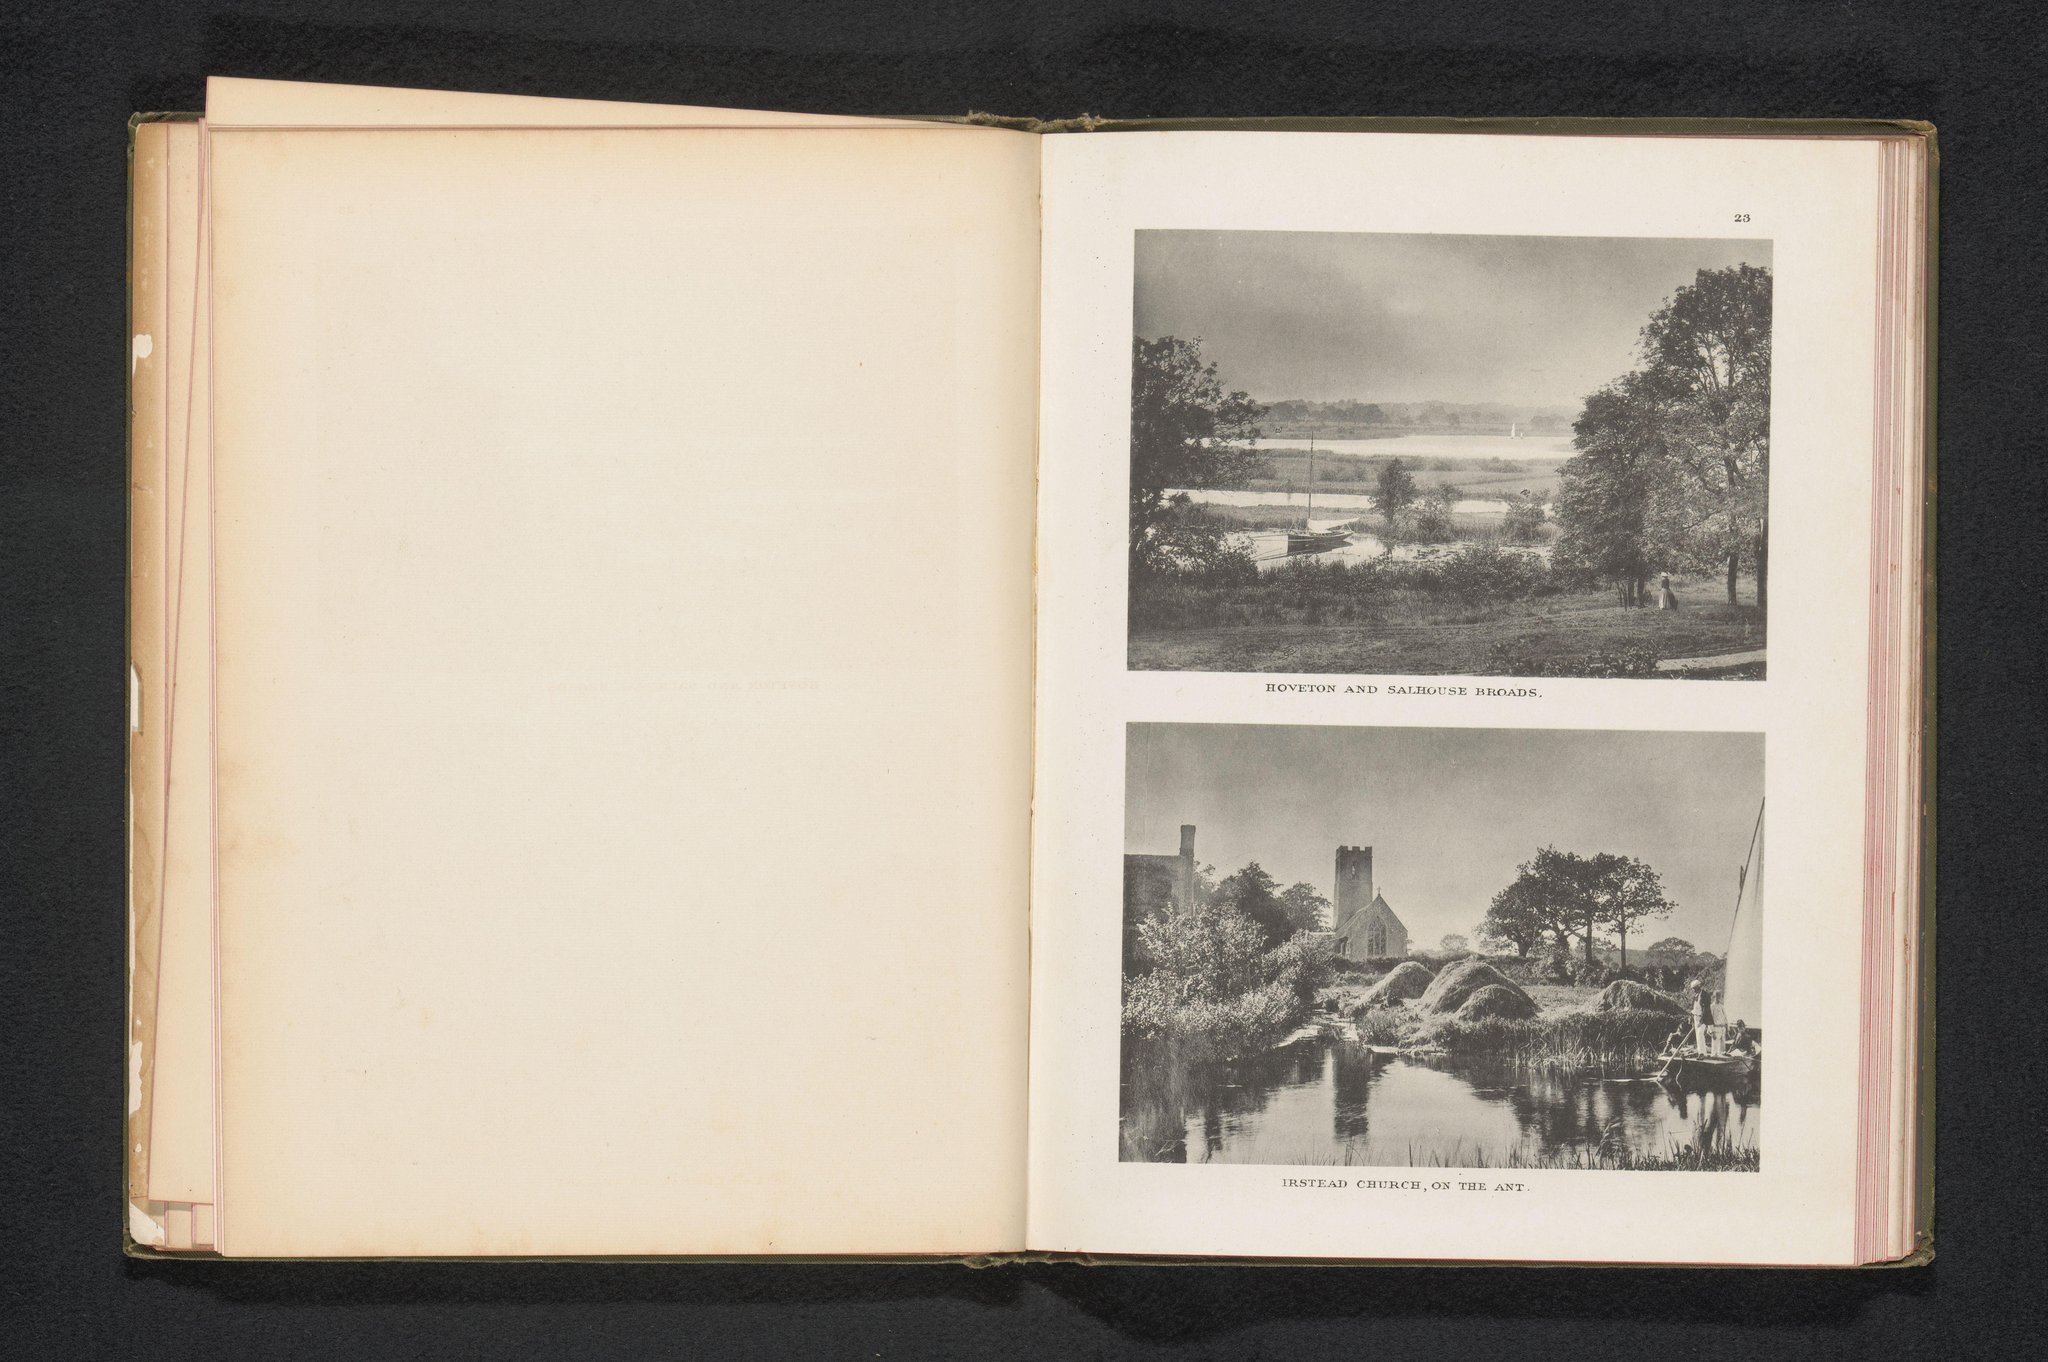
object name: page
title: Gezicht op de Hoveton en Salhouse Broads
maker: john payne jennings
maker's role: fotograaf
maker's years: 1843-1926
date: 1886-1891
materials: paper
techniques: photograph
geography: surrey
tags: landscapes with waters, waterscapes, seascapes (in the temperate zone)